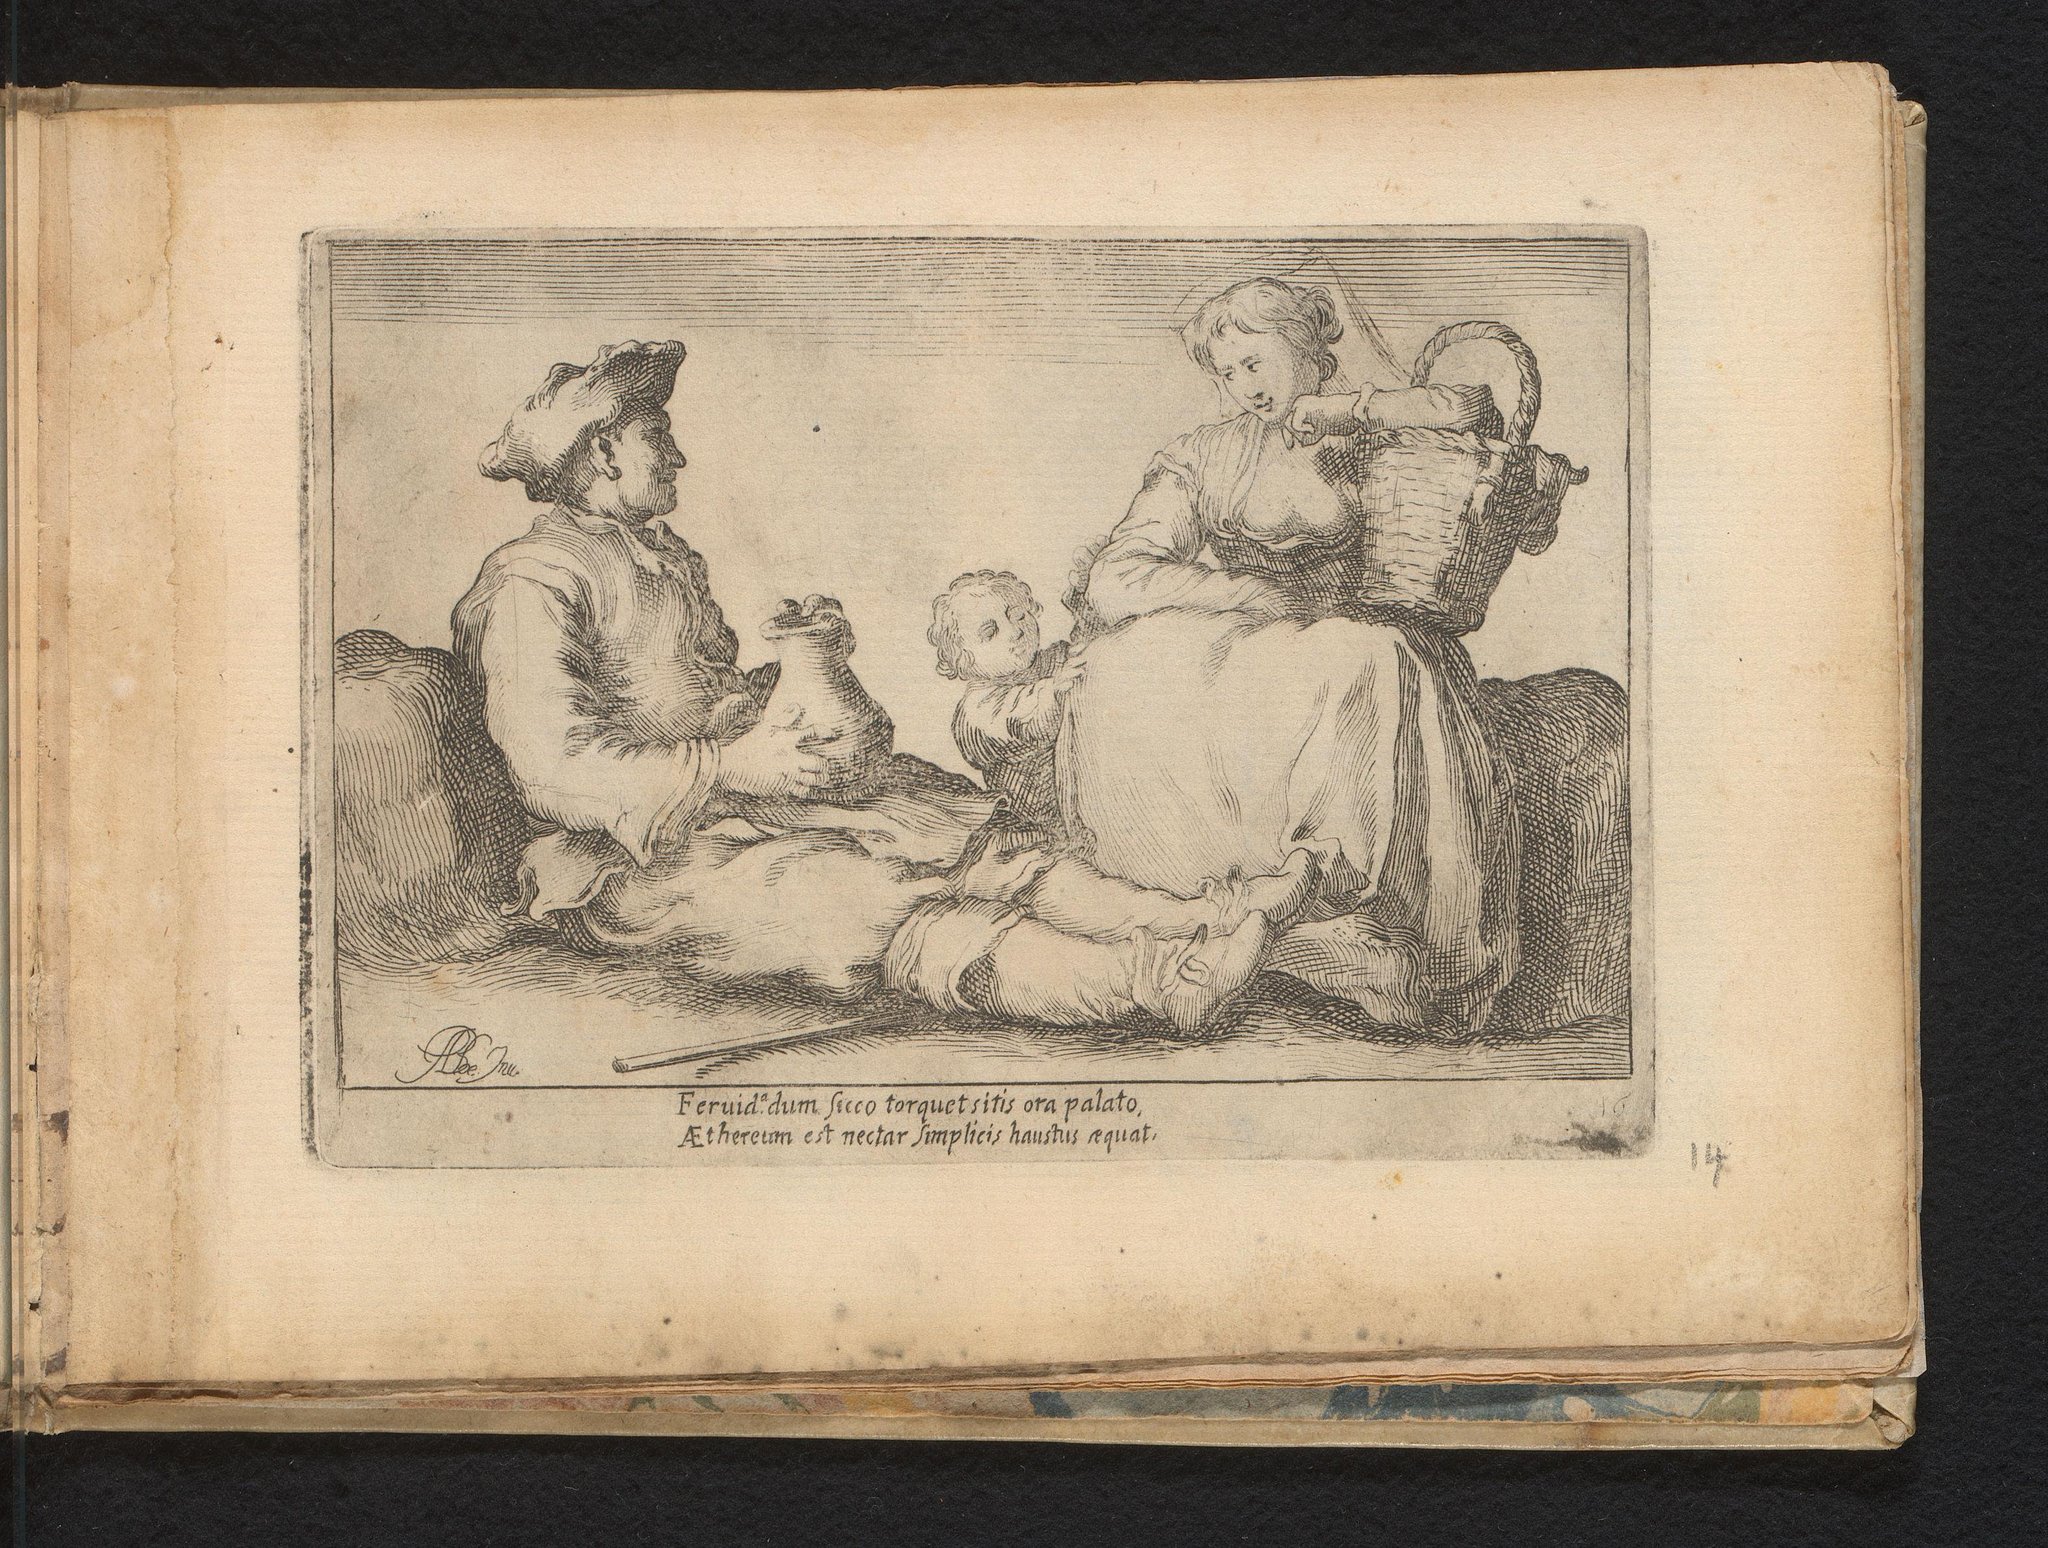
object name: print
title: Boerenfamilie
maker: Anonymous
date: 1629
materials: ink, paper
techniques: engraving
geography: europe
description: Een man, vrouw en kind rusten uit. De man zit geleund tegen een steenblok met een kruik in de handen. De vrouw zit met een mand op haar schoot, een kind trekt aan haar arm. Met tweeregelig vers in het Latijn in ondermarge. Het betreft de serie getiteld: Otia delectant faciuntq [...]. Kalfsleren band met opschrift en decoratieve kaderlijnen in pen in bruin. Voorin en achterin vier schutbladen van velijn.